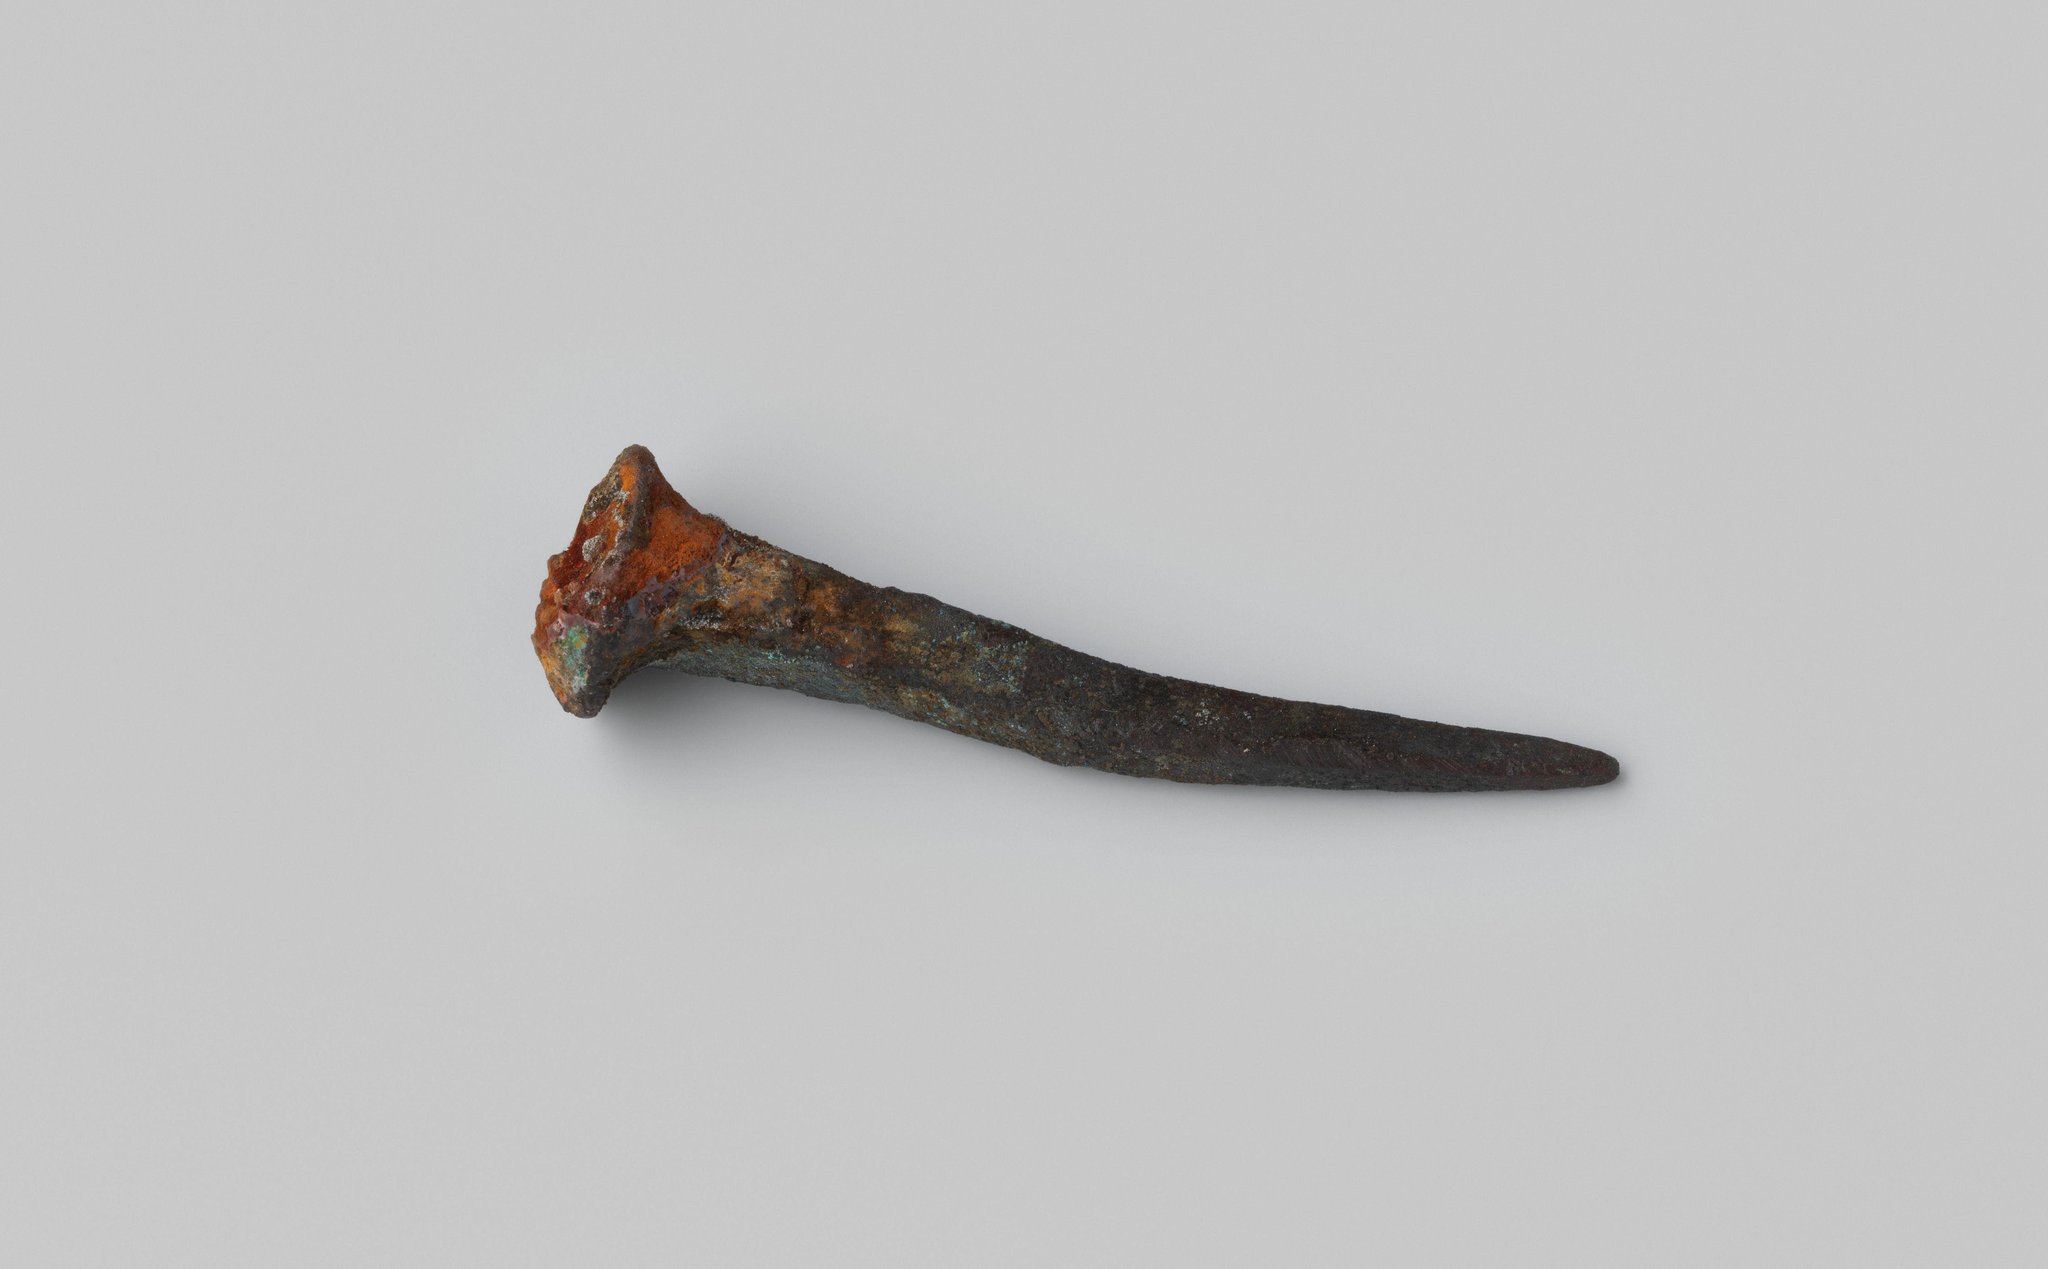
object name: nagel, spijker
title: Spijker afkomstig uit het wrak van de Oost-Indiëvaarder Hollandia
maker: Anonymous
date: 1700-1743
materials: iron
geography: netherlands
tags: verenigde oostindische compagnie, hollandia (schip)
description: Nails; square, tapering pointed shaft, flat circular head.